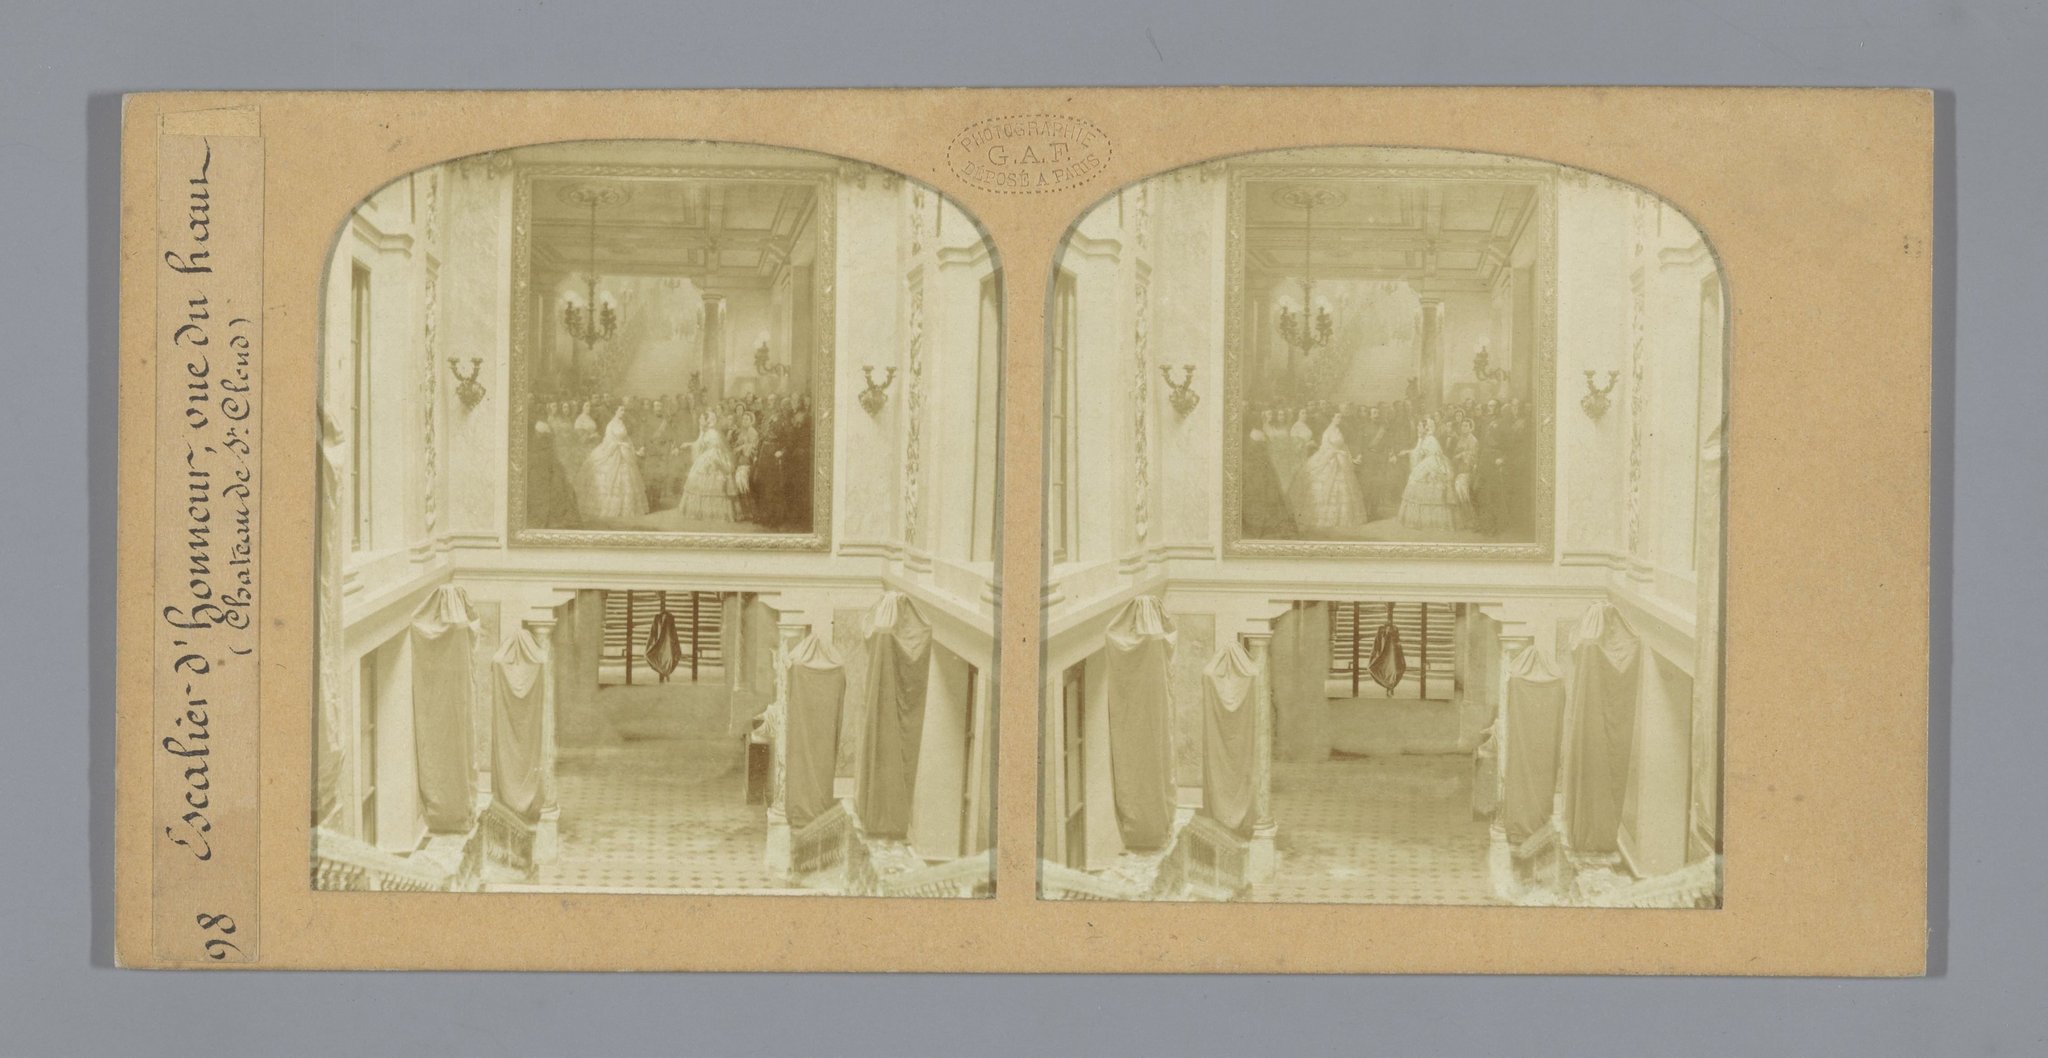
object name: tissue stereograph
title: Staatsietrap in het kasteel van Saint-Cloud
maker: florent grau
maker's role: manufacturer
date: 1858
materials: cardboard, paper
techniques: albumen print, hand coloring, perforating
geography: saint-cloud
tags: flight of steps, vestibule, hall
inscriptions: inscription: ‘Déposé a Paris’, number: ‘98’, inscription: ‘f1,25/ J’